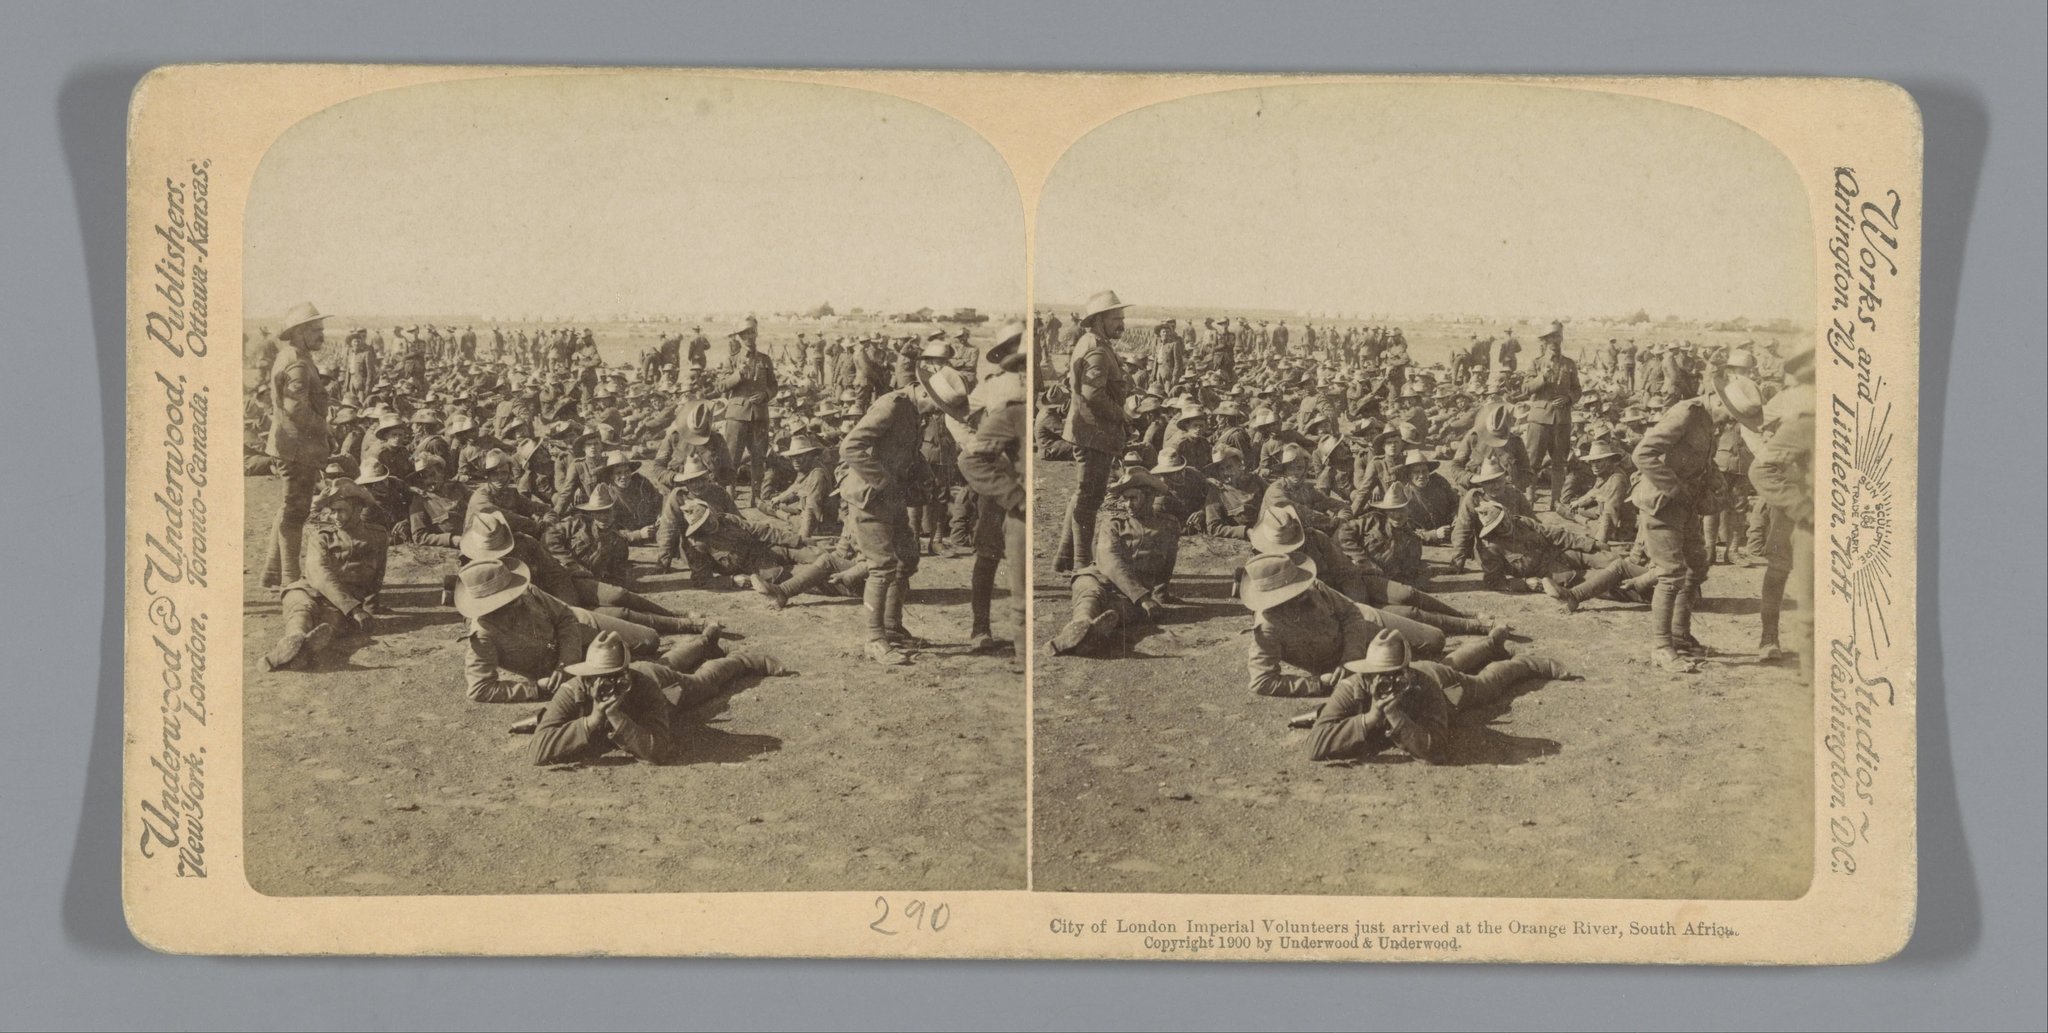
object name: stereograph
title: City of London Imperial Volunteers just arrived at the Orange River, S. Africa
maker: Anonymous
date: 1900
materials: cardboard, paper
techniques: albumen print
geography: orange river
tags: the company, the unit, the troop ~ military service, volunteers ~ enlisting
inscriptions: number: ‘290’, copyright notice: ‘Copyright 1900 by Underwood & Underwood.’, inscription, inscription: ‘Works and Studios ~/ Arlington, N.J. Littleton, N.H. Washington, D.C.’